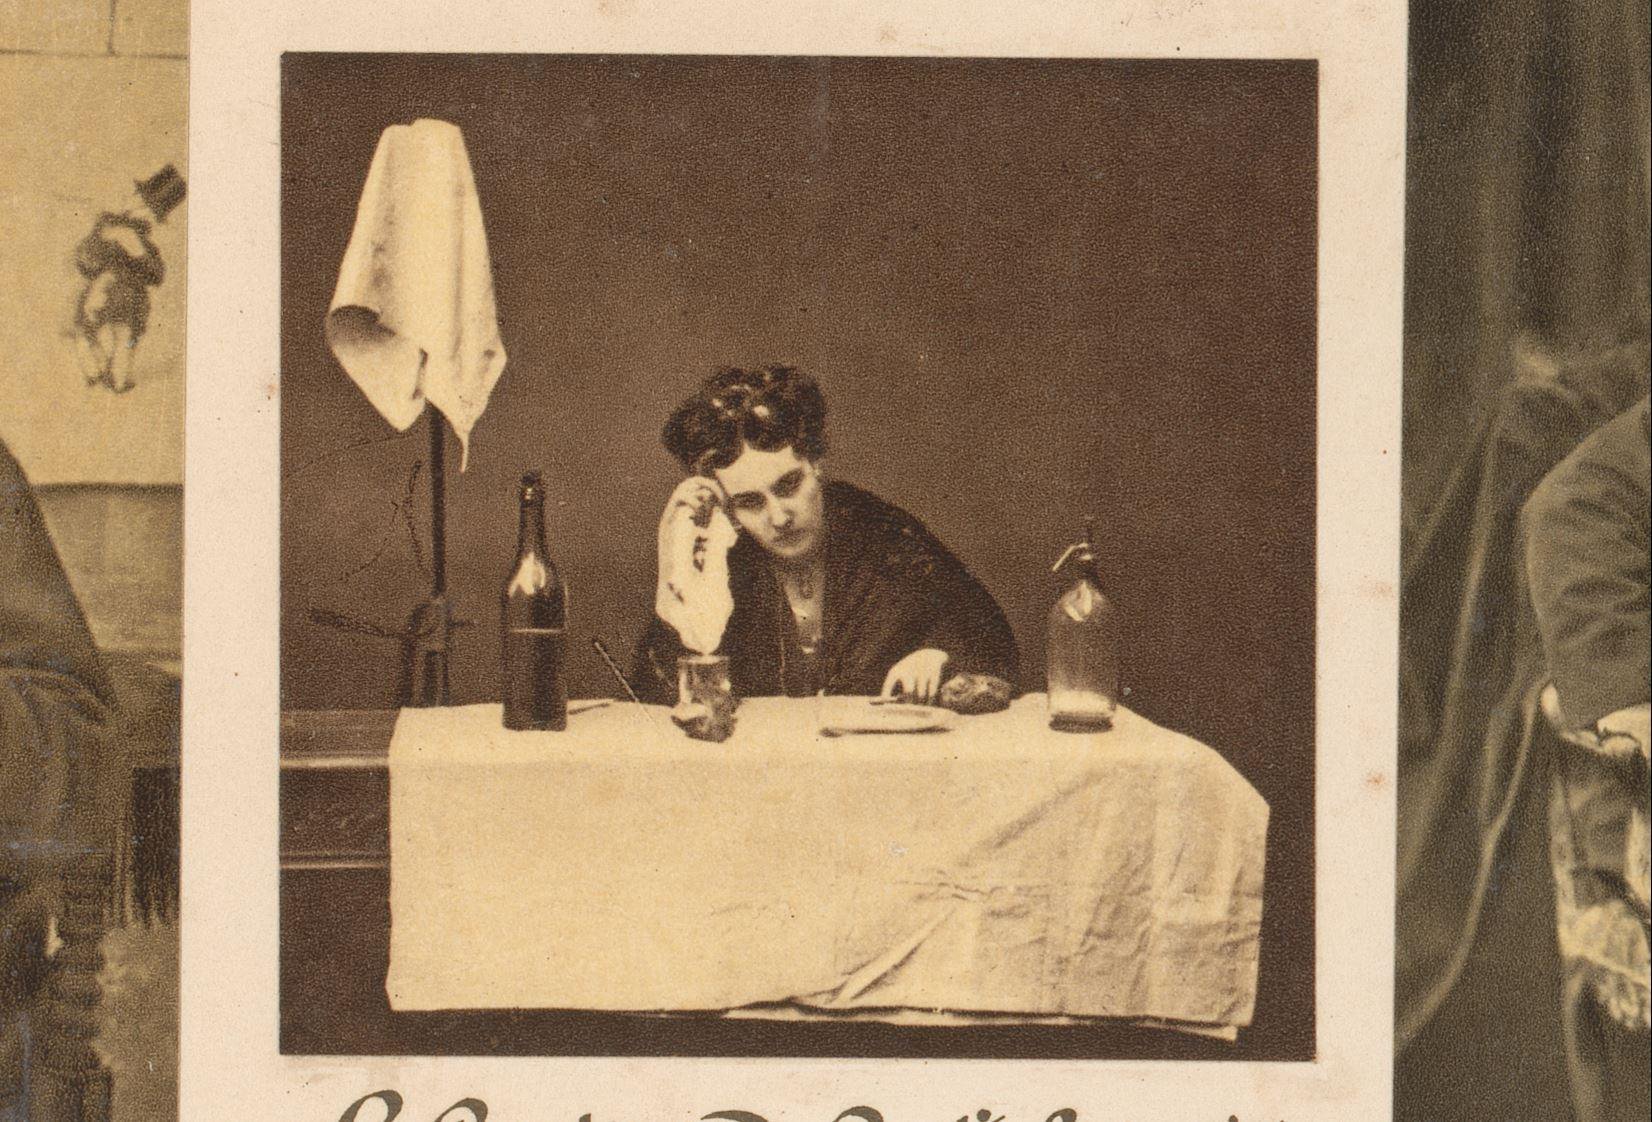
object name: photograph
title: La Comtesse de Castiglione (vers 1865)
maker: Anonymous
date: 1865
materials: paper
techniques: rotogravure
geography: france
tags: paris, artist's model, sitter, historical persons, france